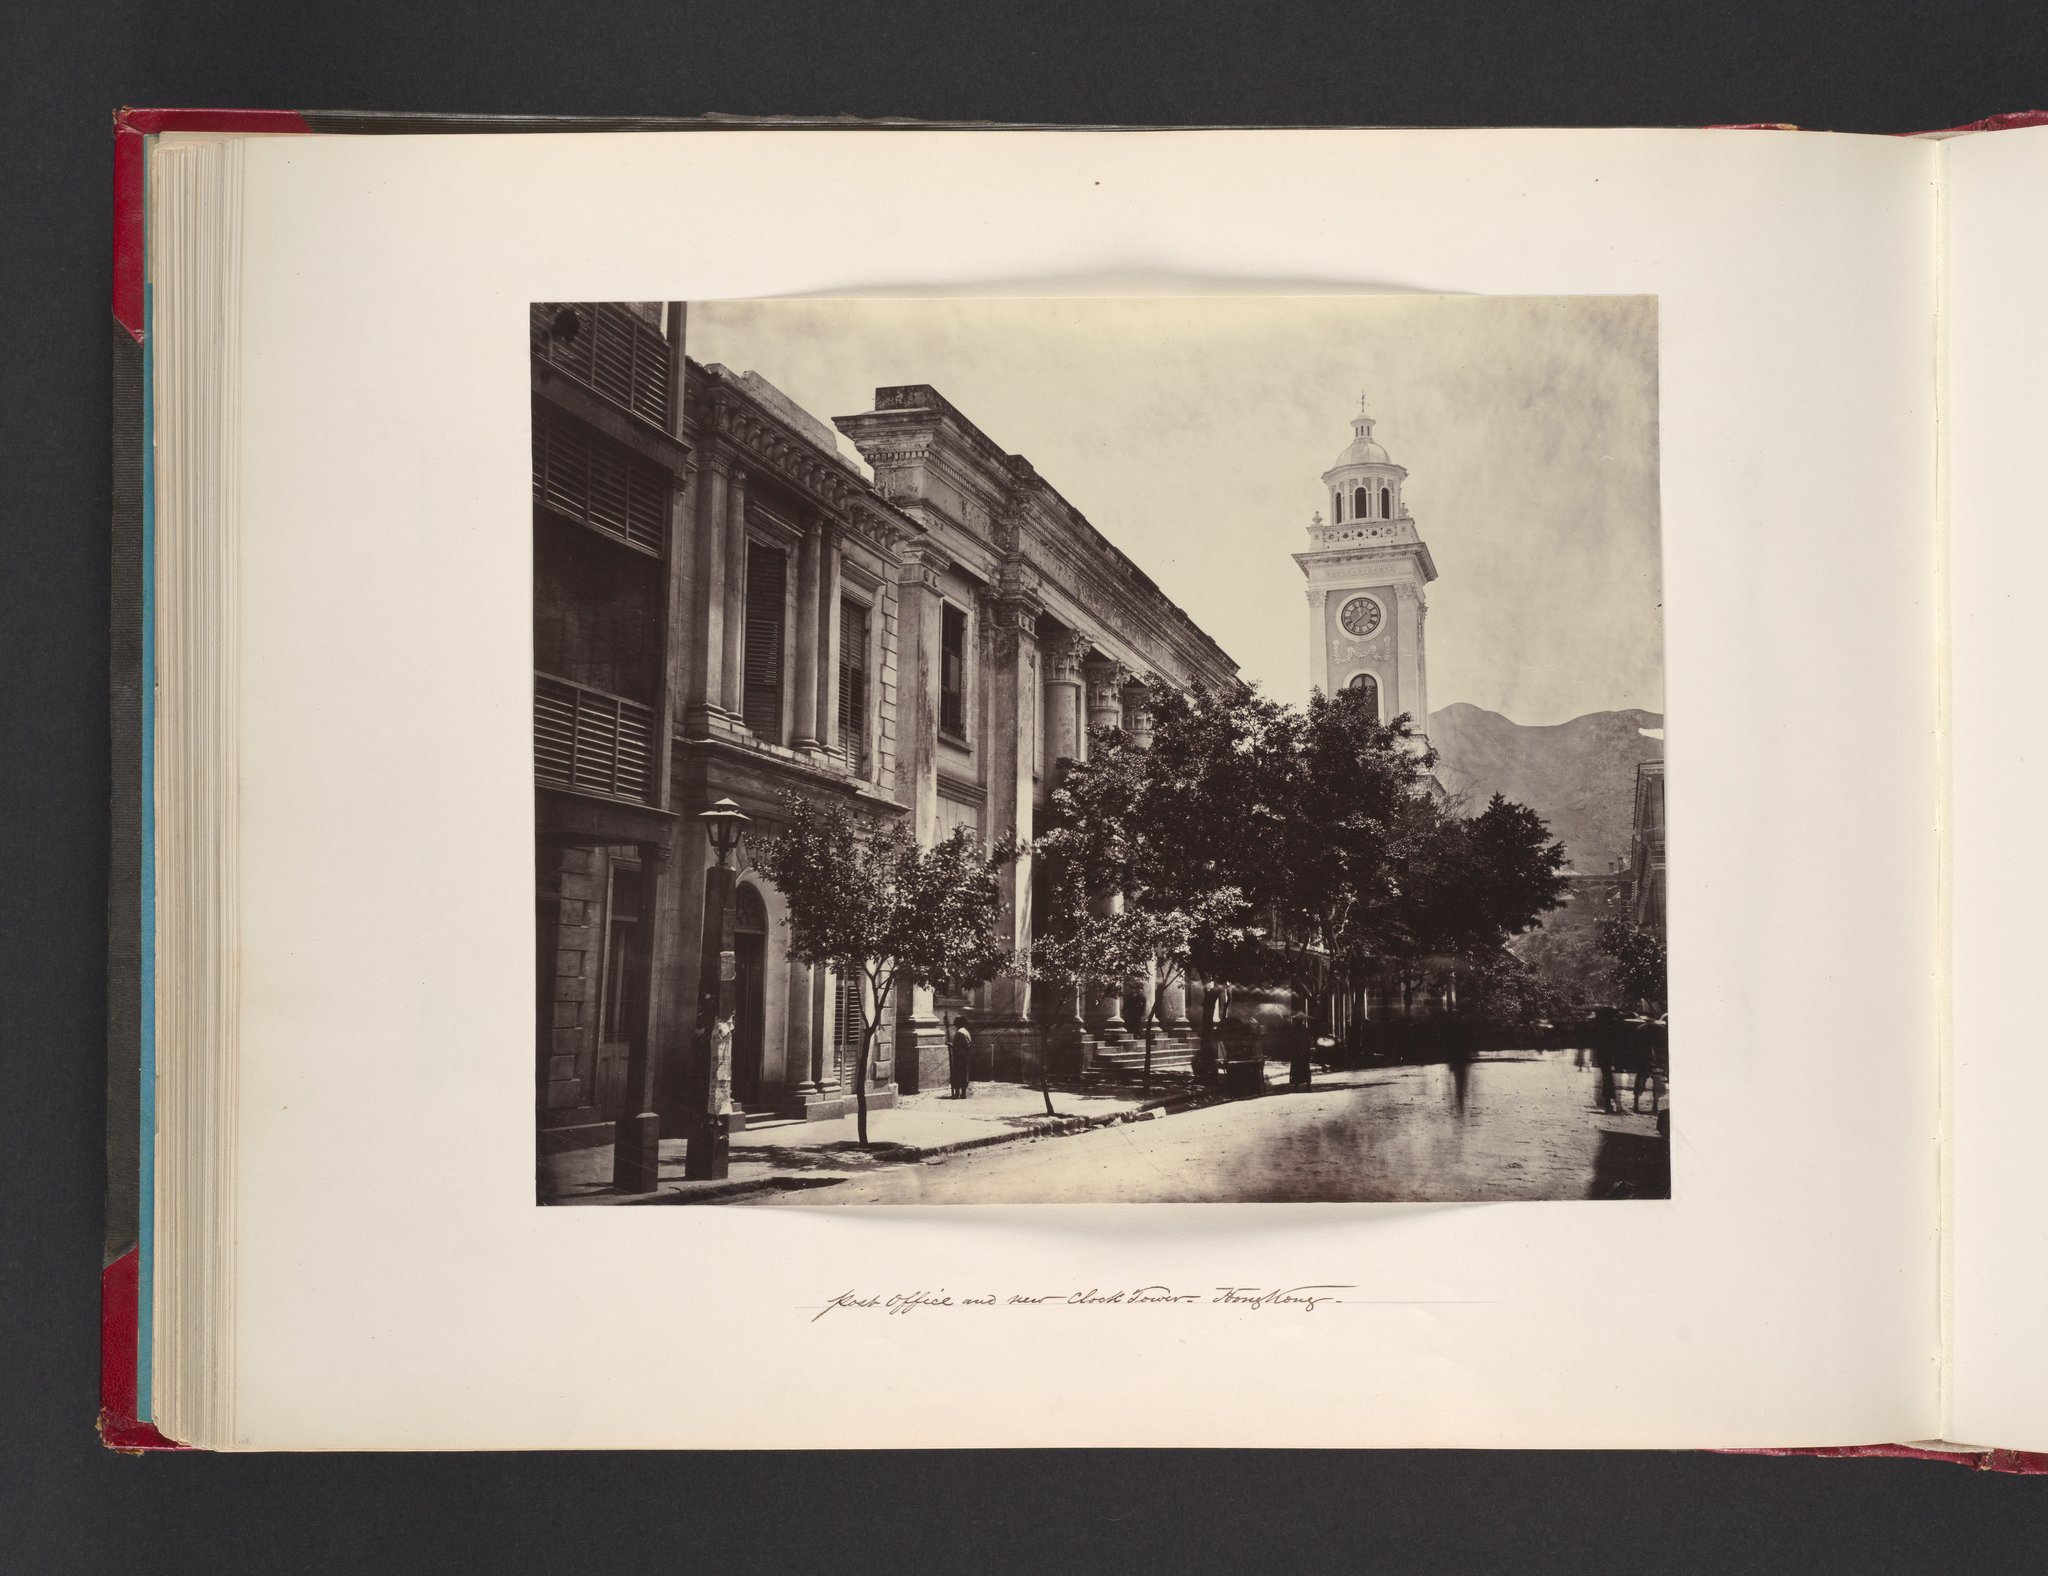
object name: photograph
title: Post Office and New Clock Tower. Hong Kong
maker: john thomson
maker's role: artist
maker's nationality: british, scottish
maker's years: 1837-1921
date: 1865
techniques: albumen silver print, glass negative